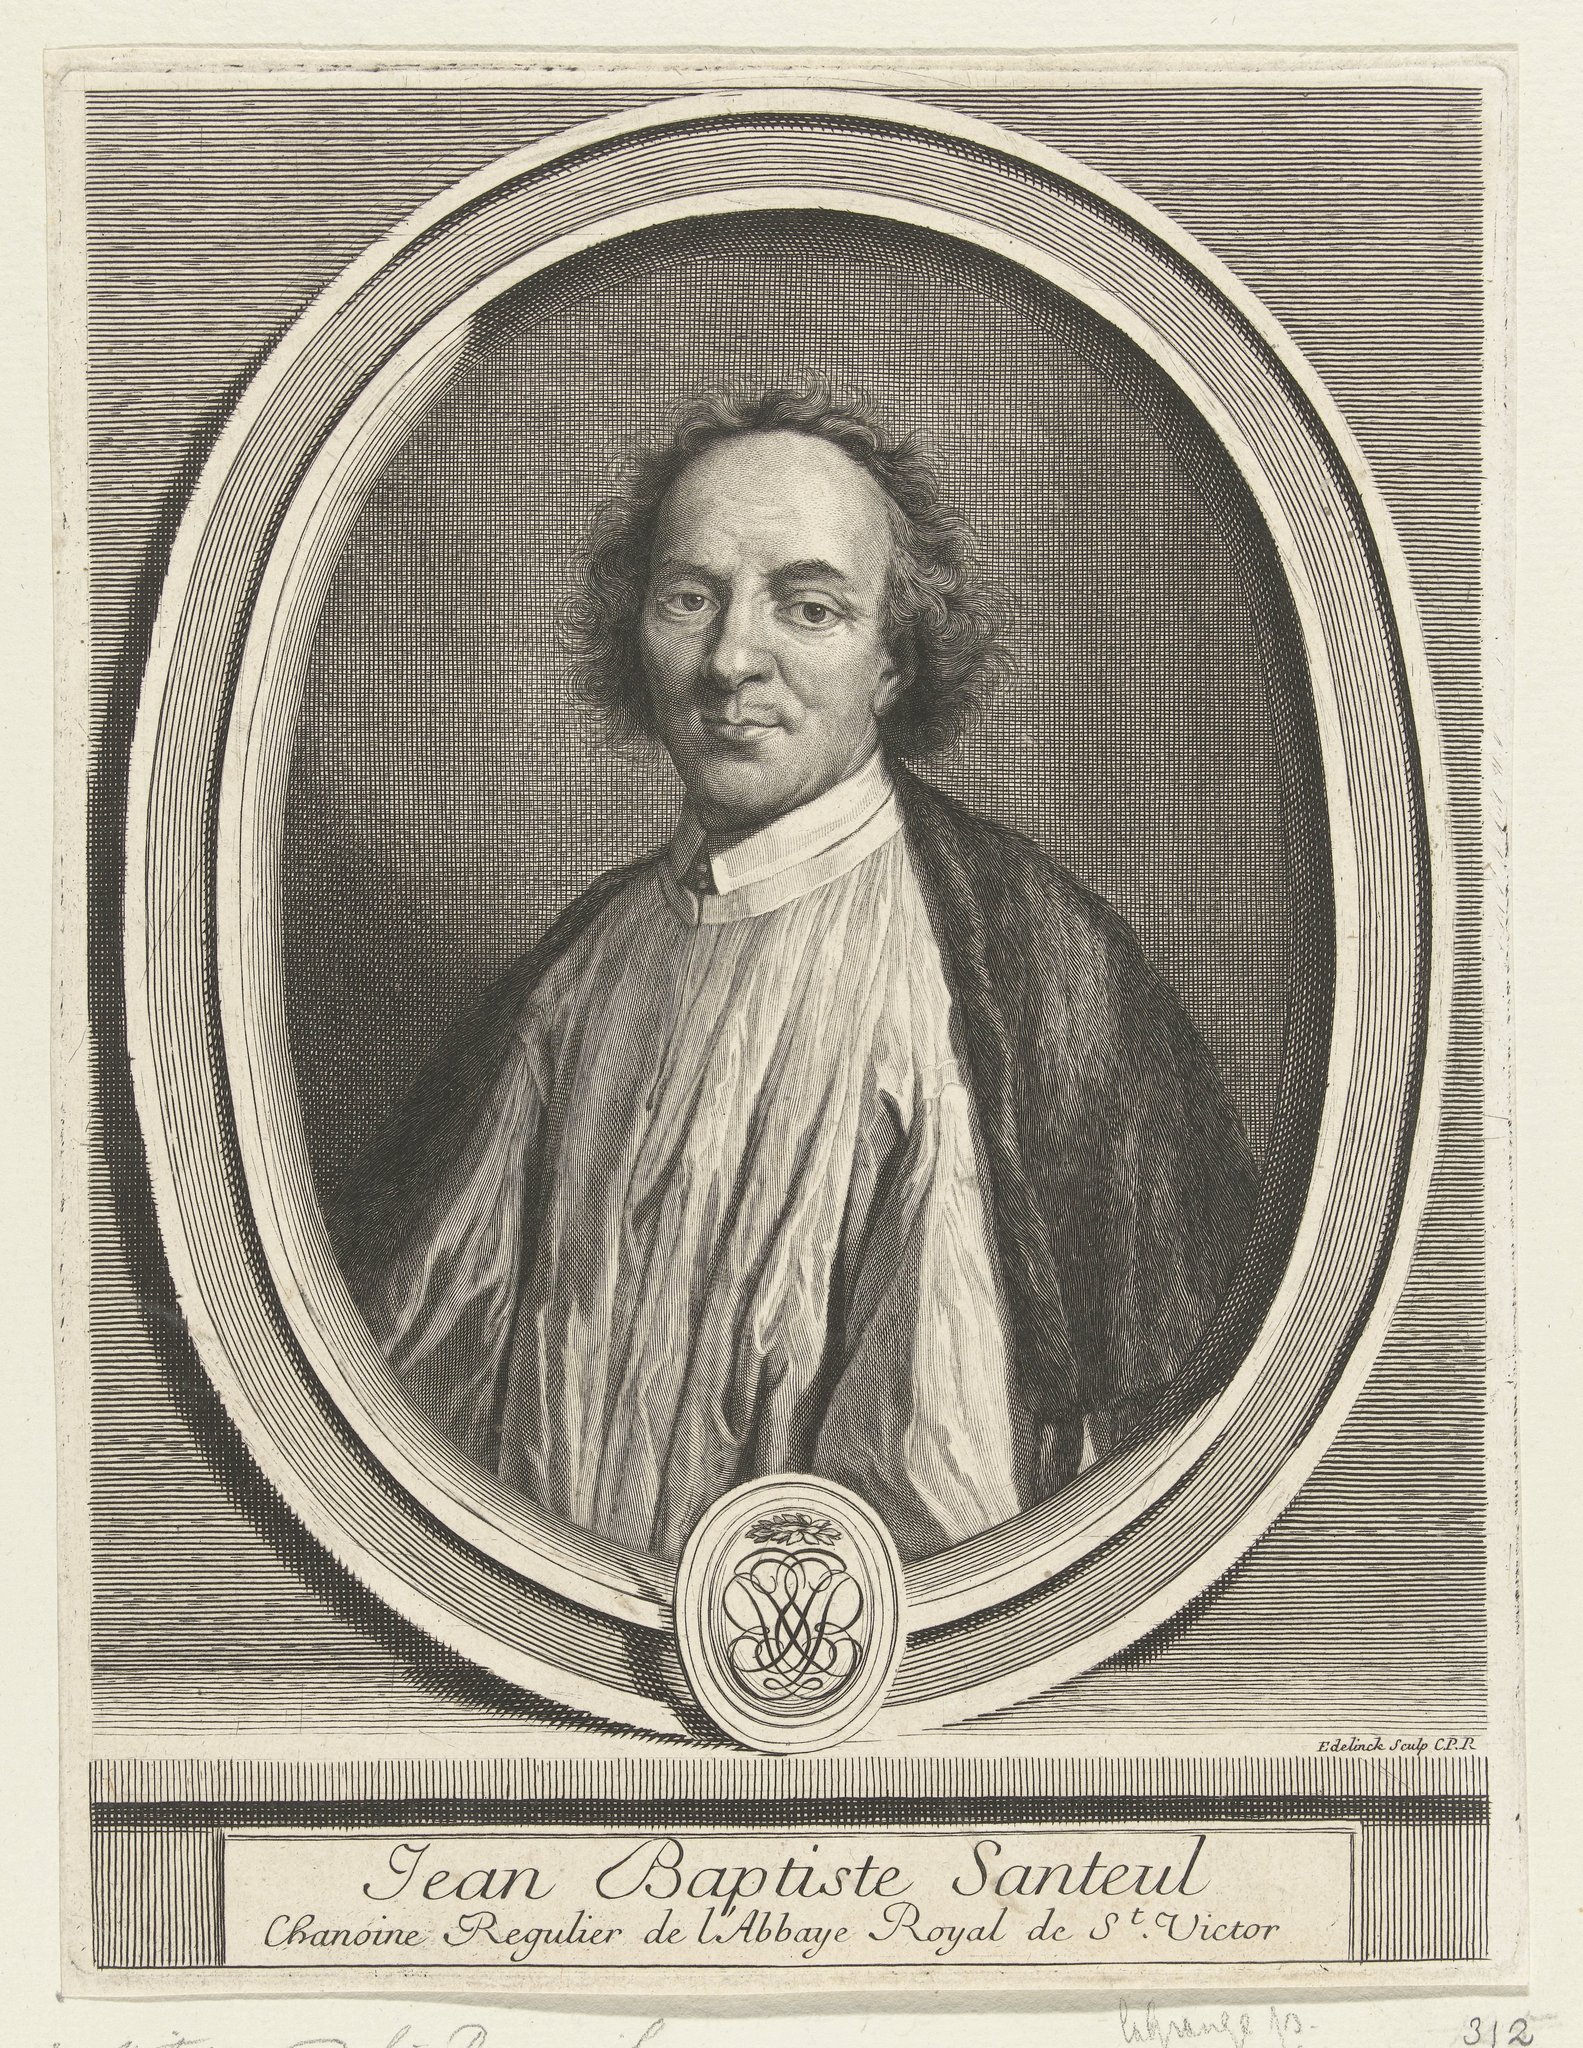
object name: print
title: Portret van Jean-Baptiste Santeuil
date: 1666-1707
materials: paper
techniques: engraving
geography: paris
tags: paris, jean de santeul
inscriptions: collector's mark: Lugt 240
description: De Franse kanunnik en dichter Jean-Baptiste Santeuil (1630-1697), afgebeeld in ovale omlijsting met wapen.